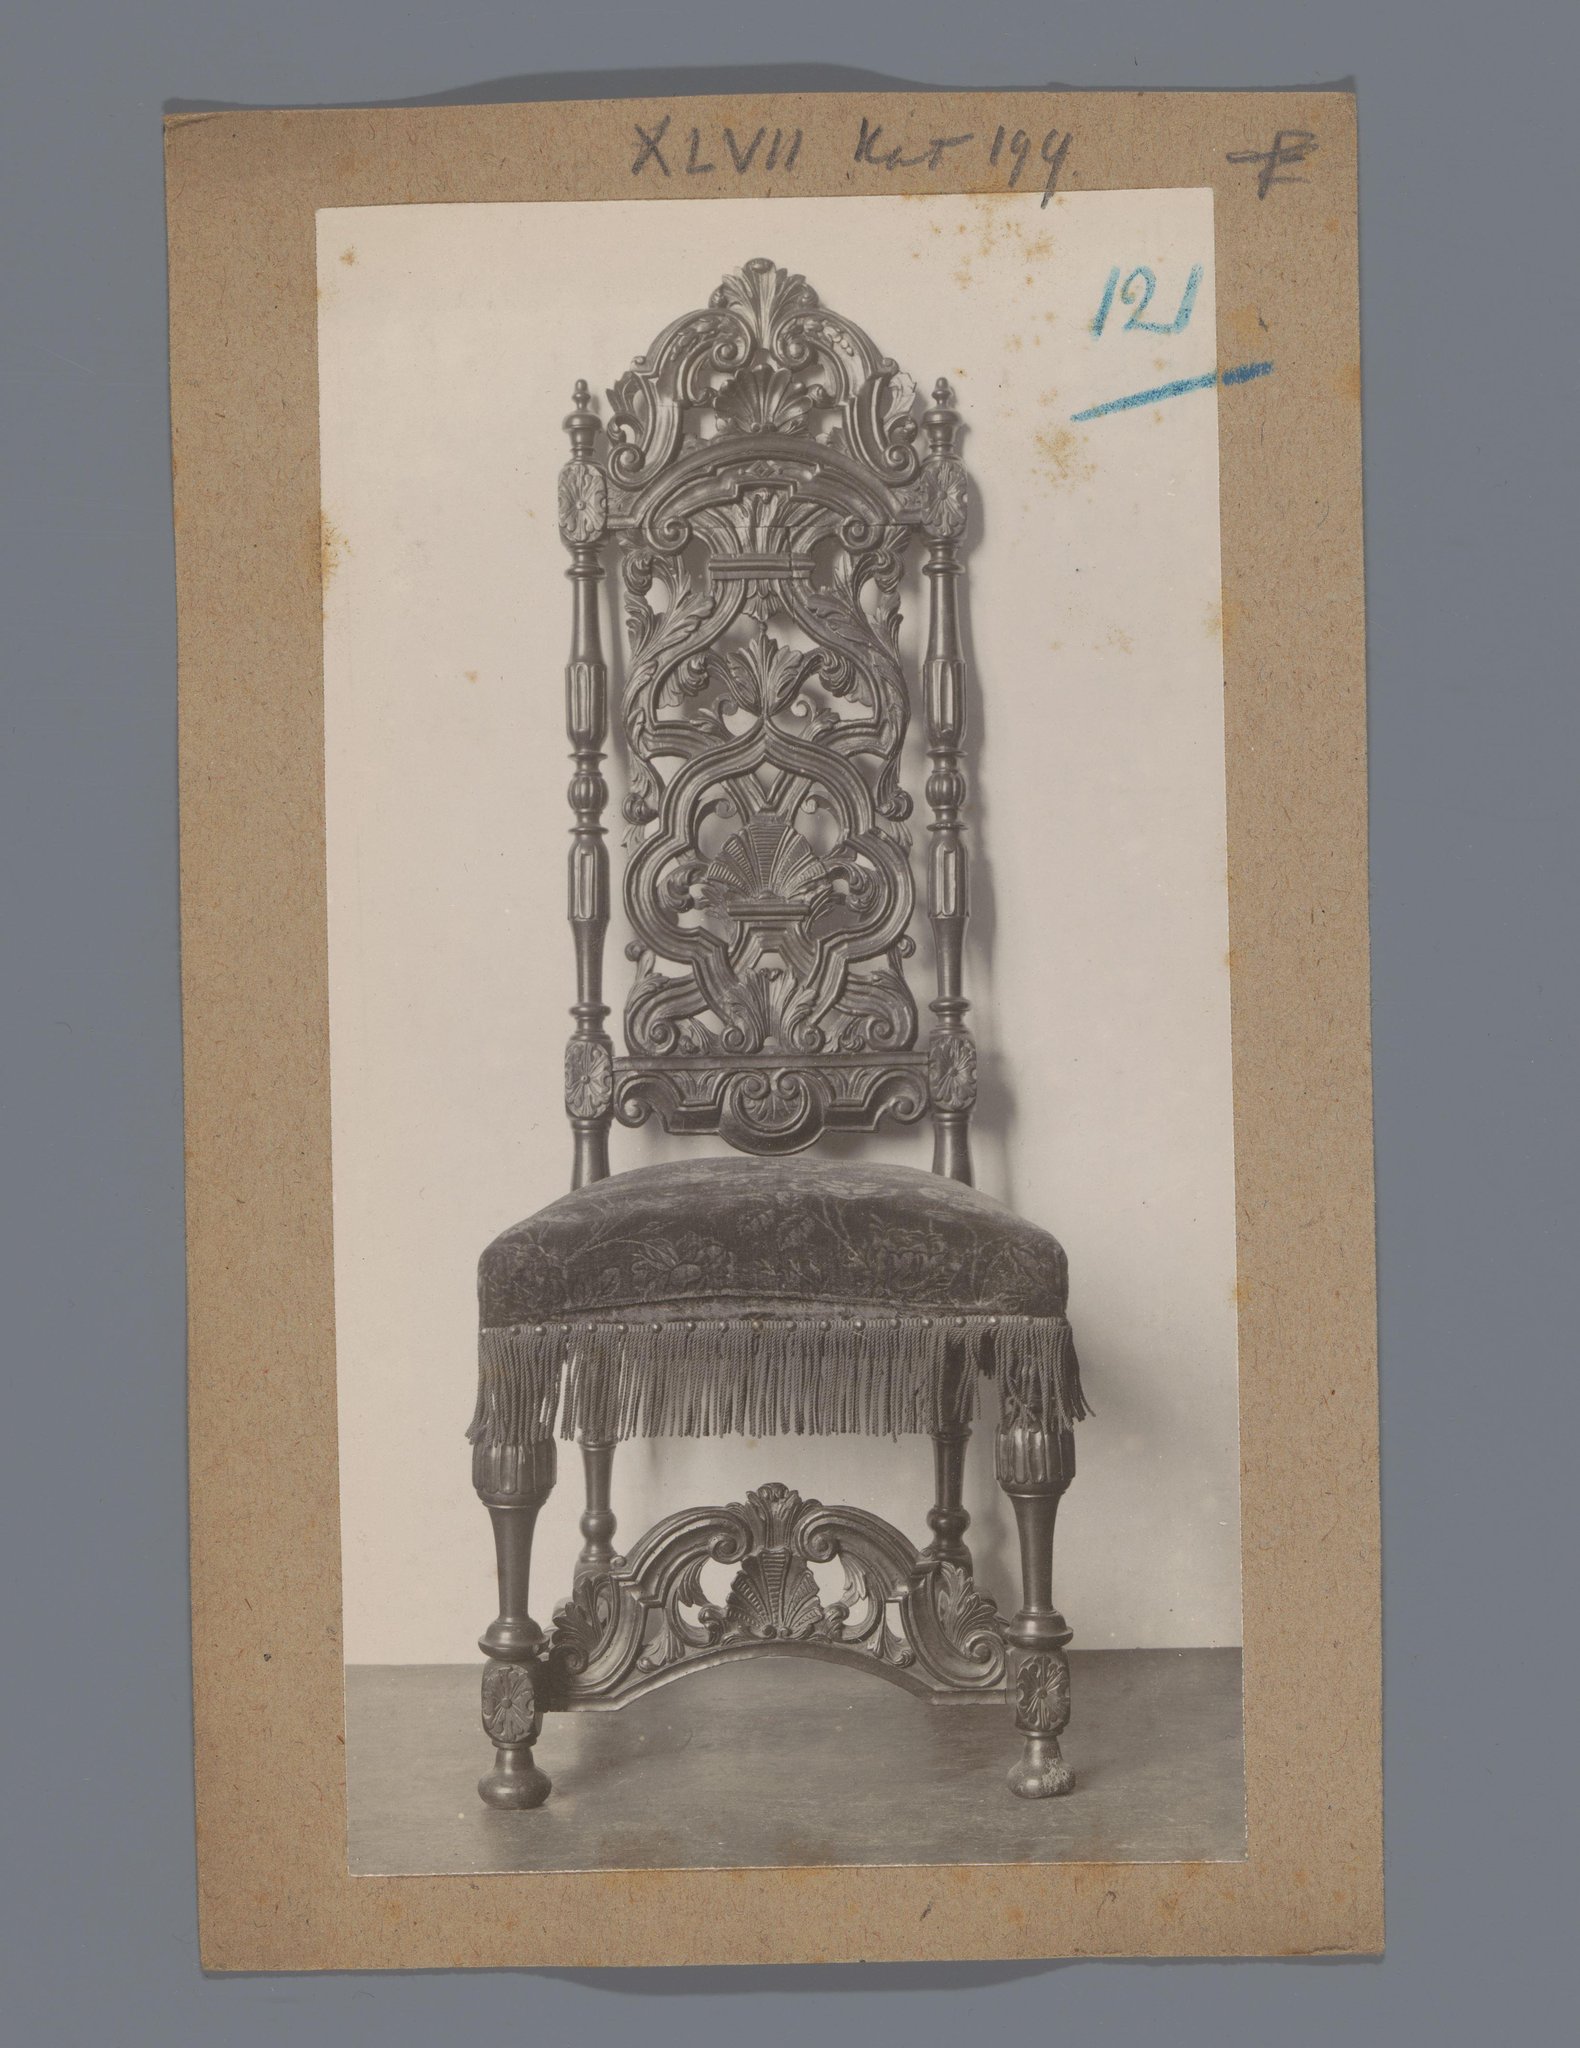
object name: photograph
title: Stoel gedecoreerd organische motieven (vermoedelijk) in het Rijksmuseum te Amsterdam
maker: Anonymous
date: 1875-1900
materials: photographic support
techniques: matte daylight collodion silver print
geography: amsterdam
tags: chair, ornament derived from plant forms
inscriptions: collector's mark: ‘Instituut voor kunst-nijverheidsonderwijs Gabriël Metsustraat No. 16, Amsterdam’, number: ‘XLVII kat 194 121.’